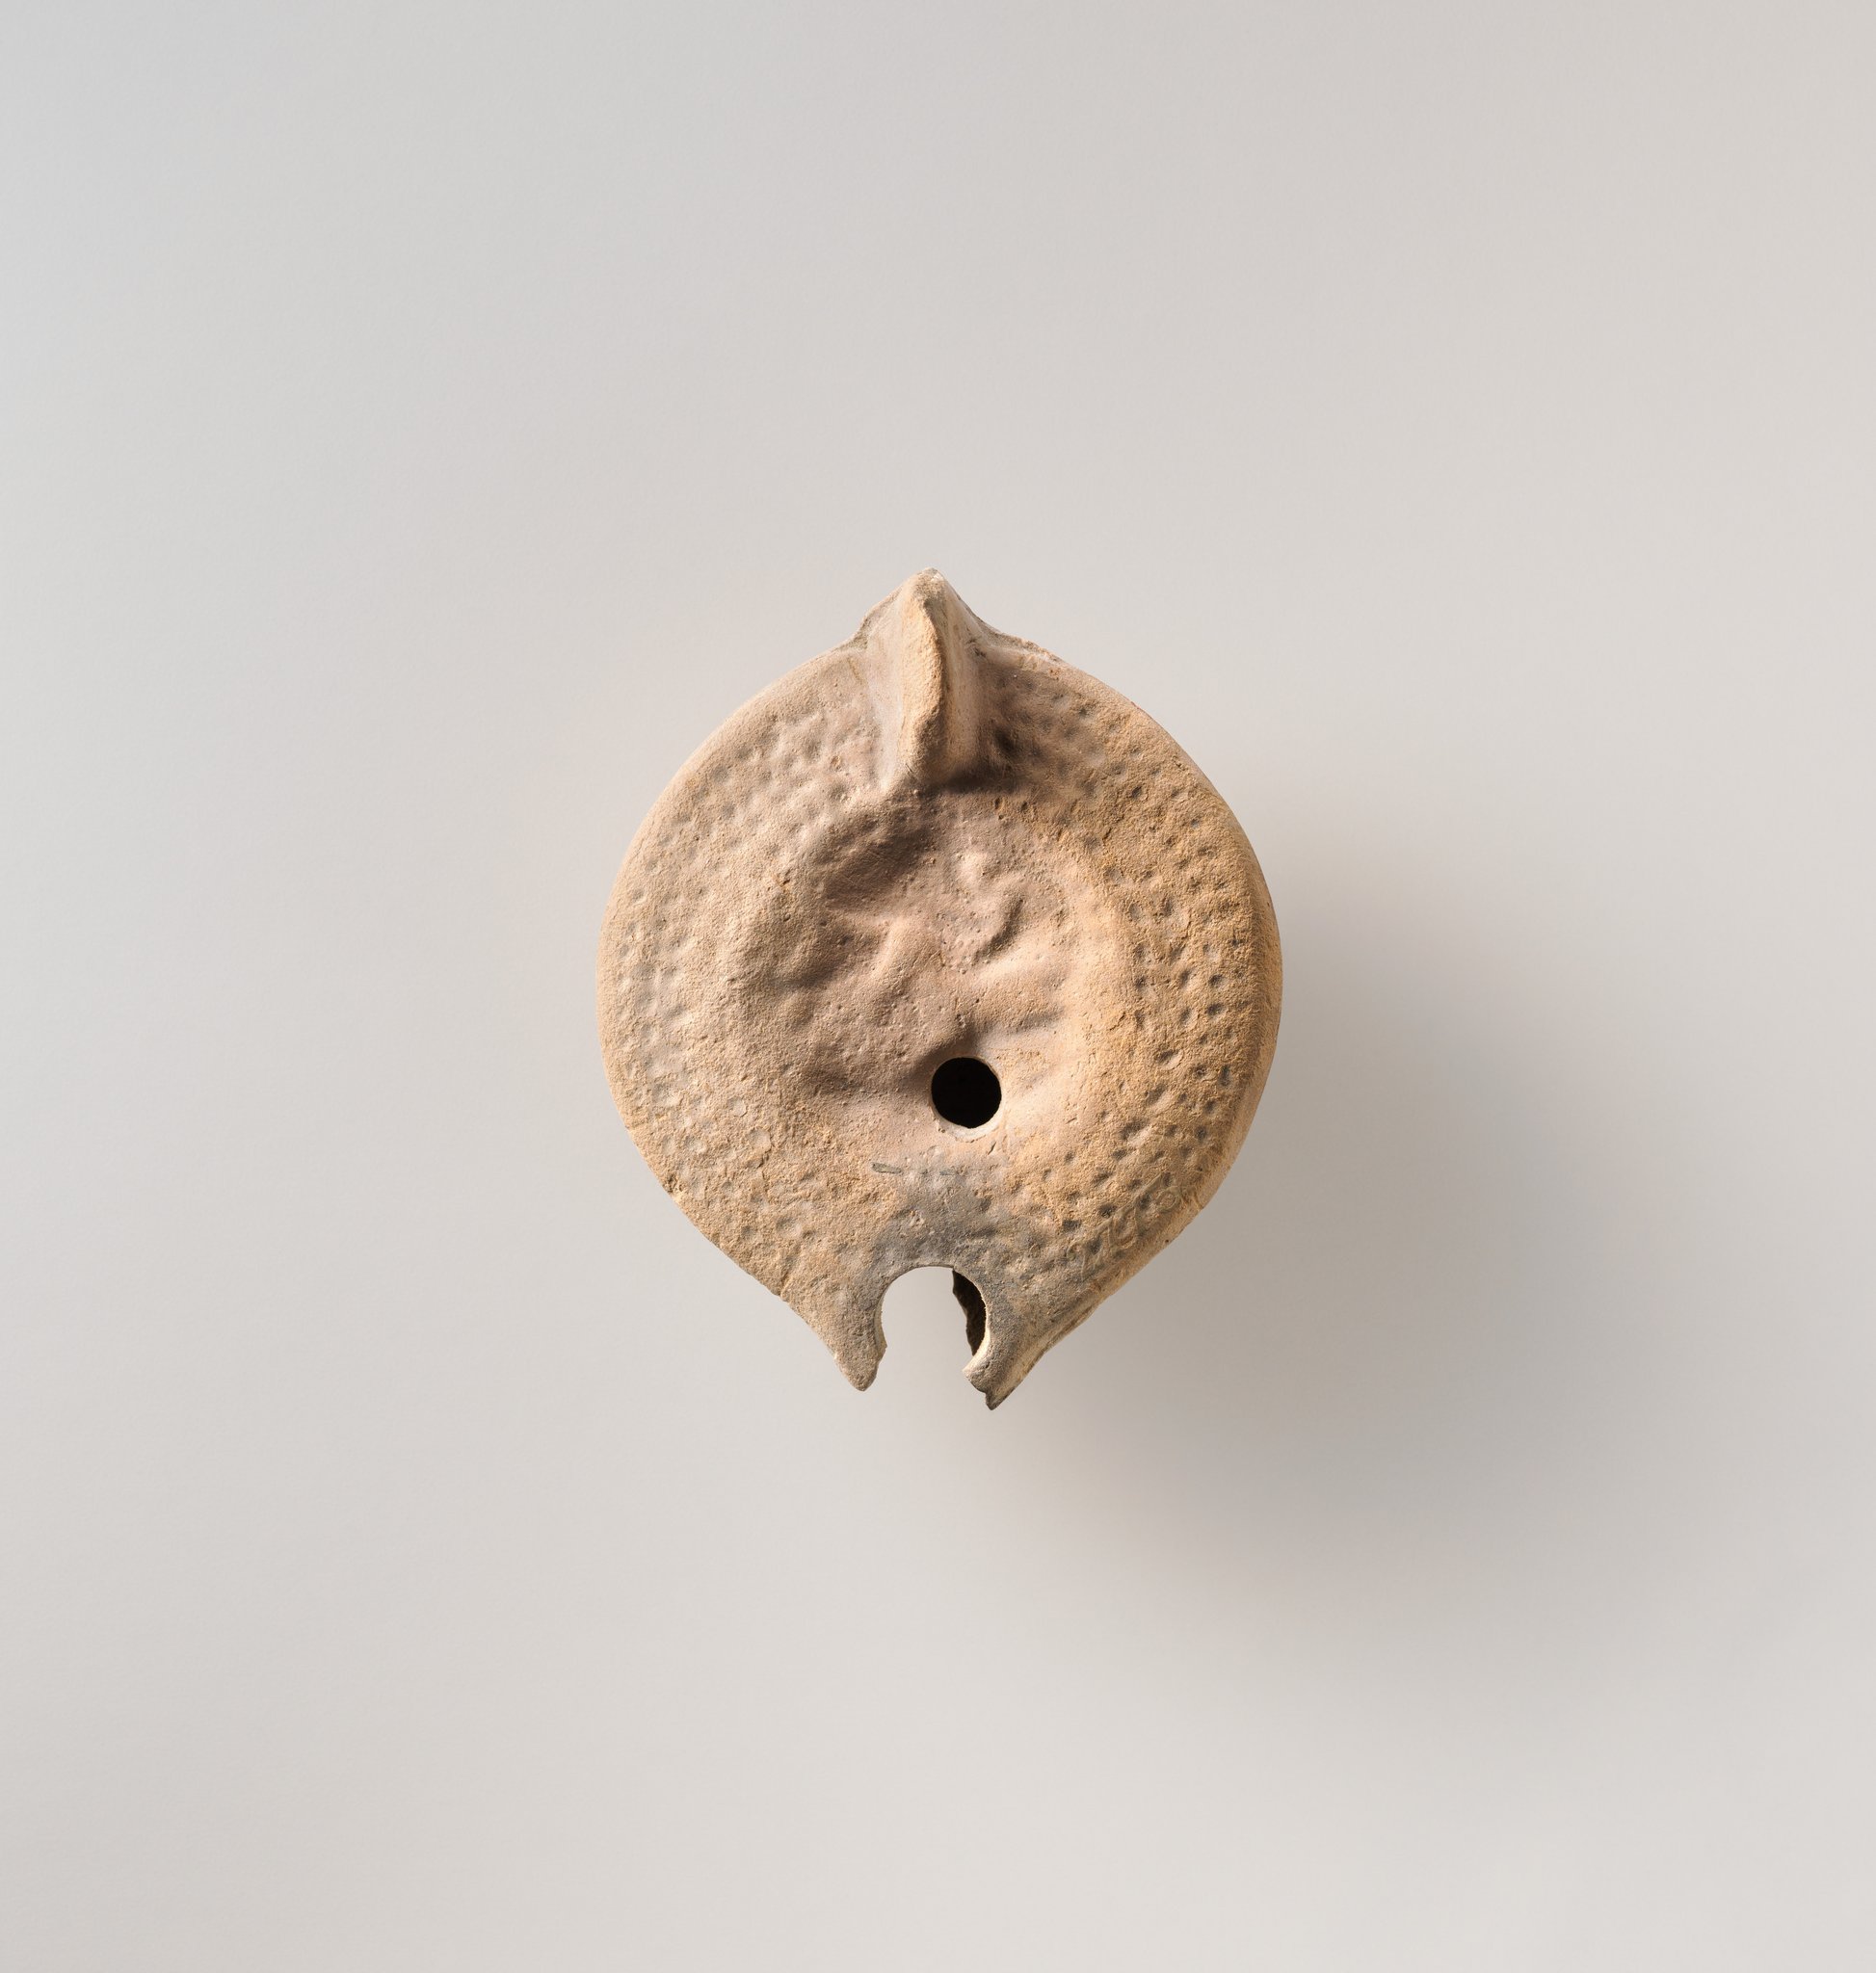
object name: lamp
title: Terracotta oil lamp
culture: roman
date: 201-300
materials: terracotta